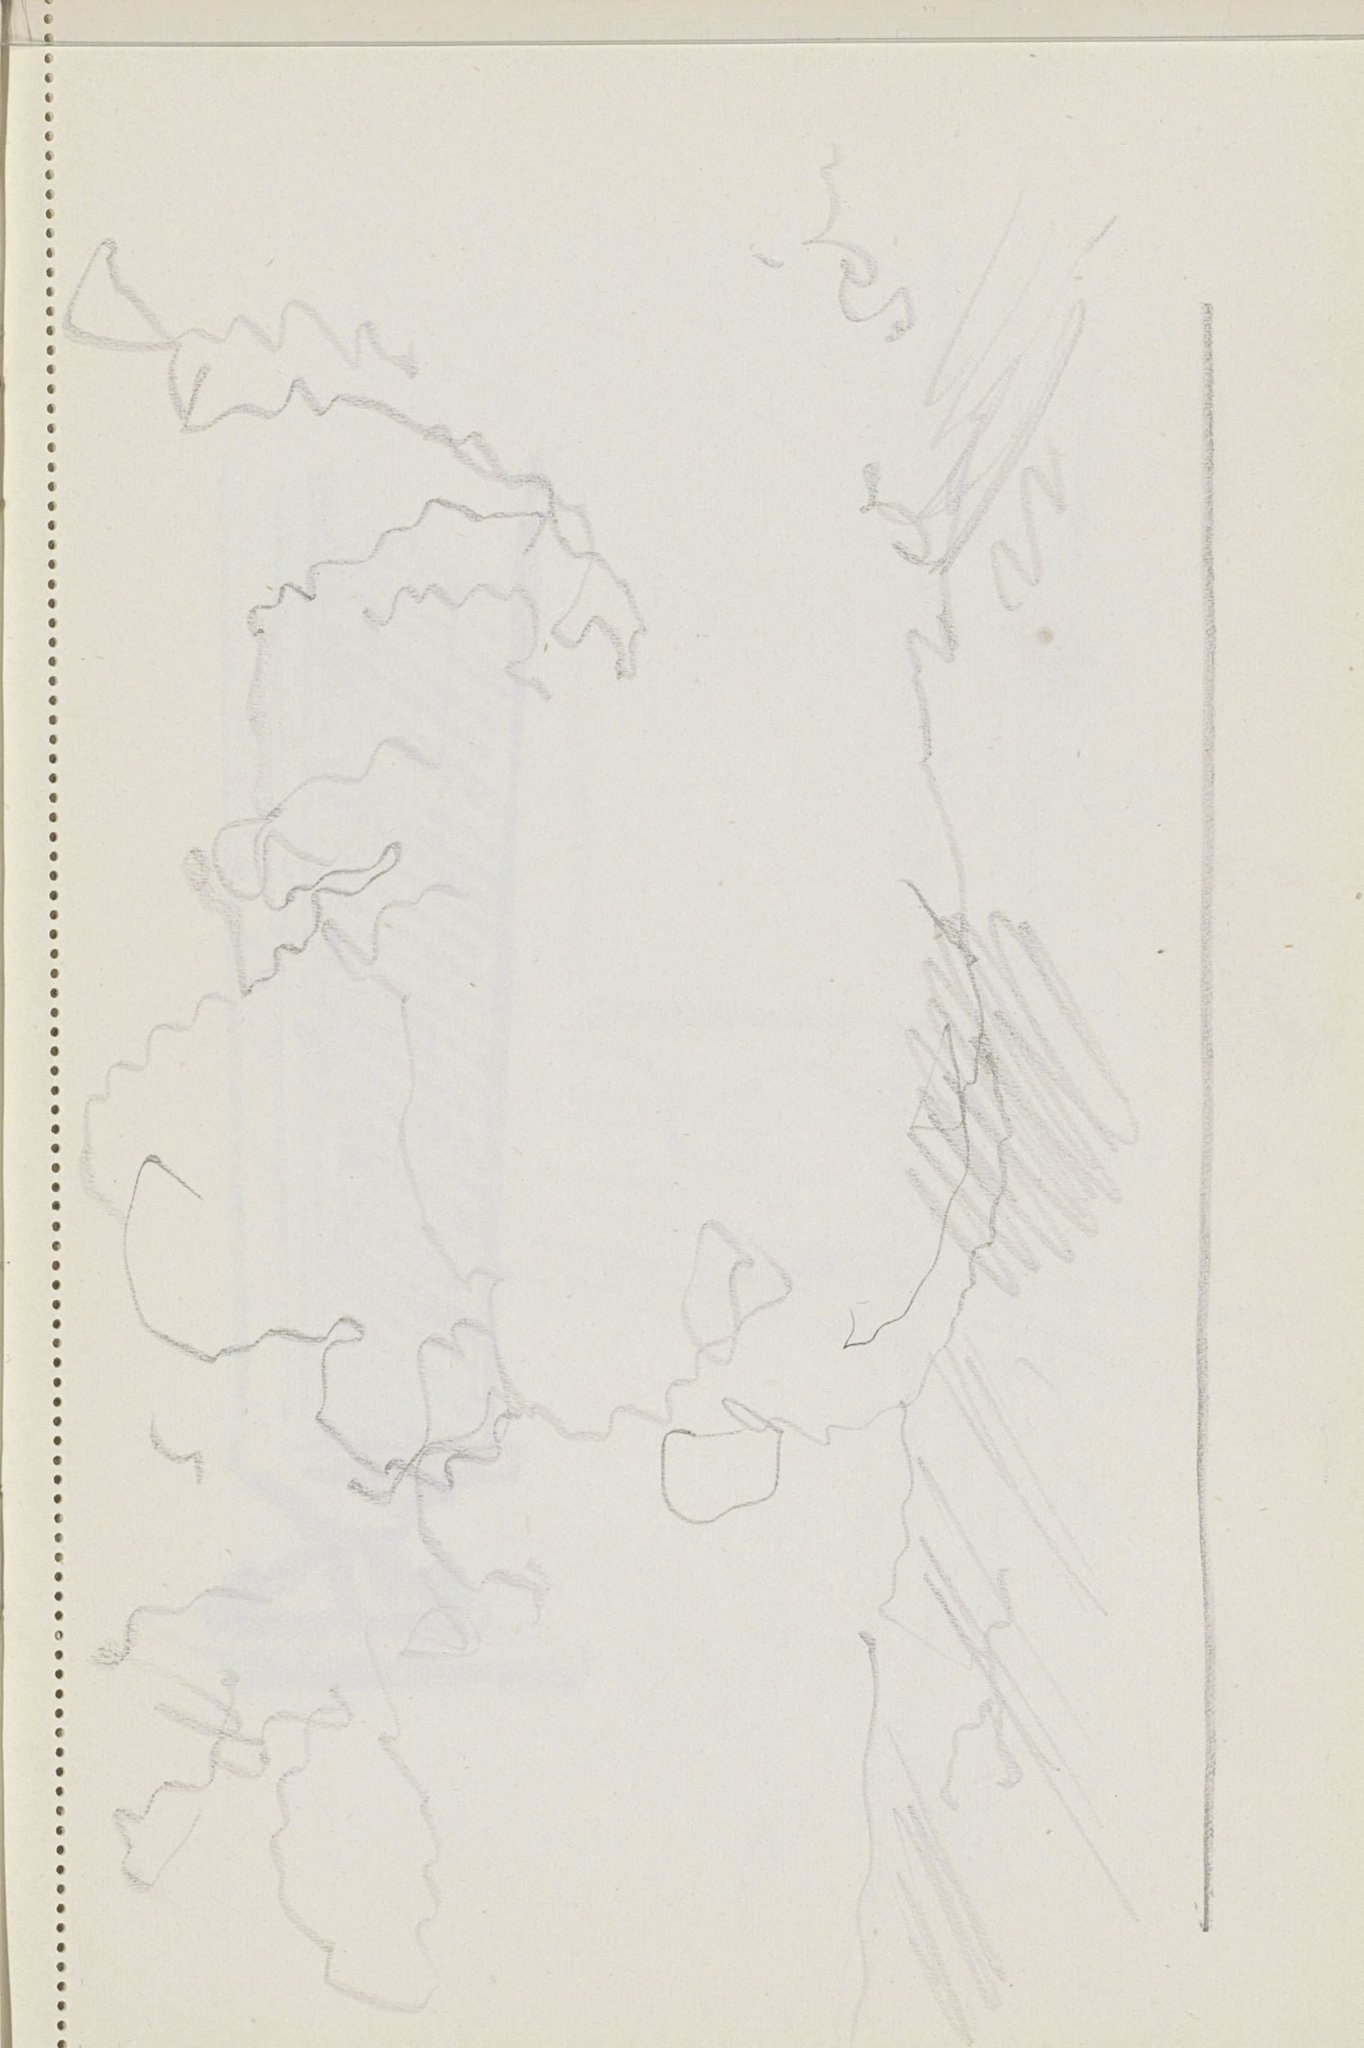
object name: sketchbook leaf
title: Wolkenlucht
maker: cornelis vreedenburgh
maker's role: draughtsman, print maker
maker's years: 1880-1946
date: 1890-1946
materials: paper, pencil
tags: clouds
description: Blad 55 recto uit een schetsboek met uit 75 bladen.